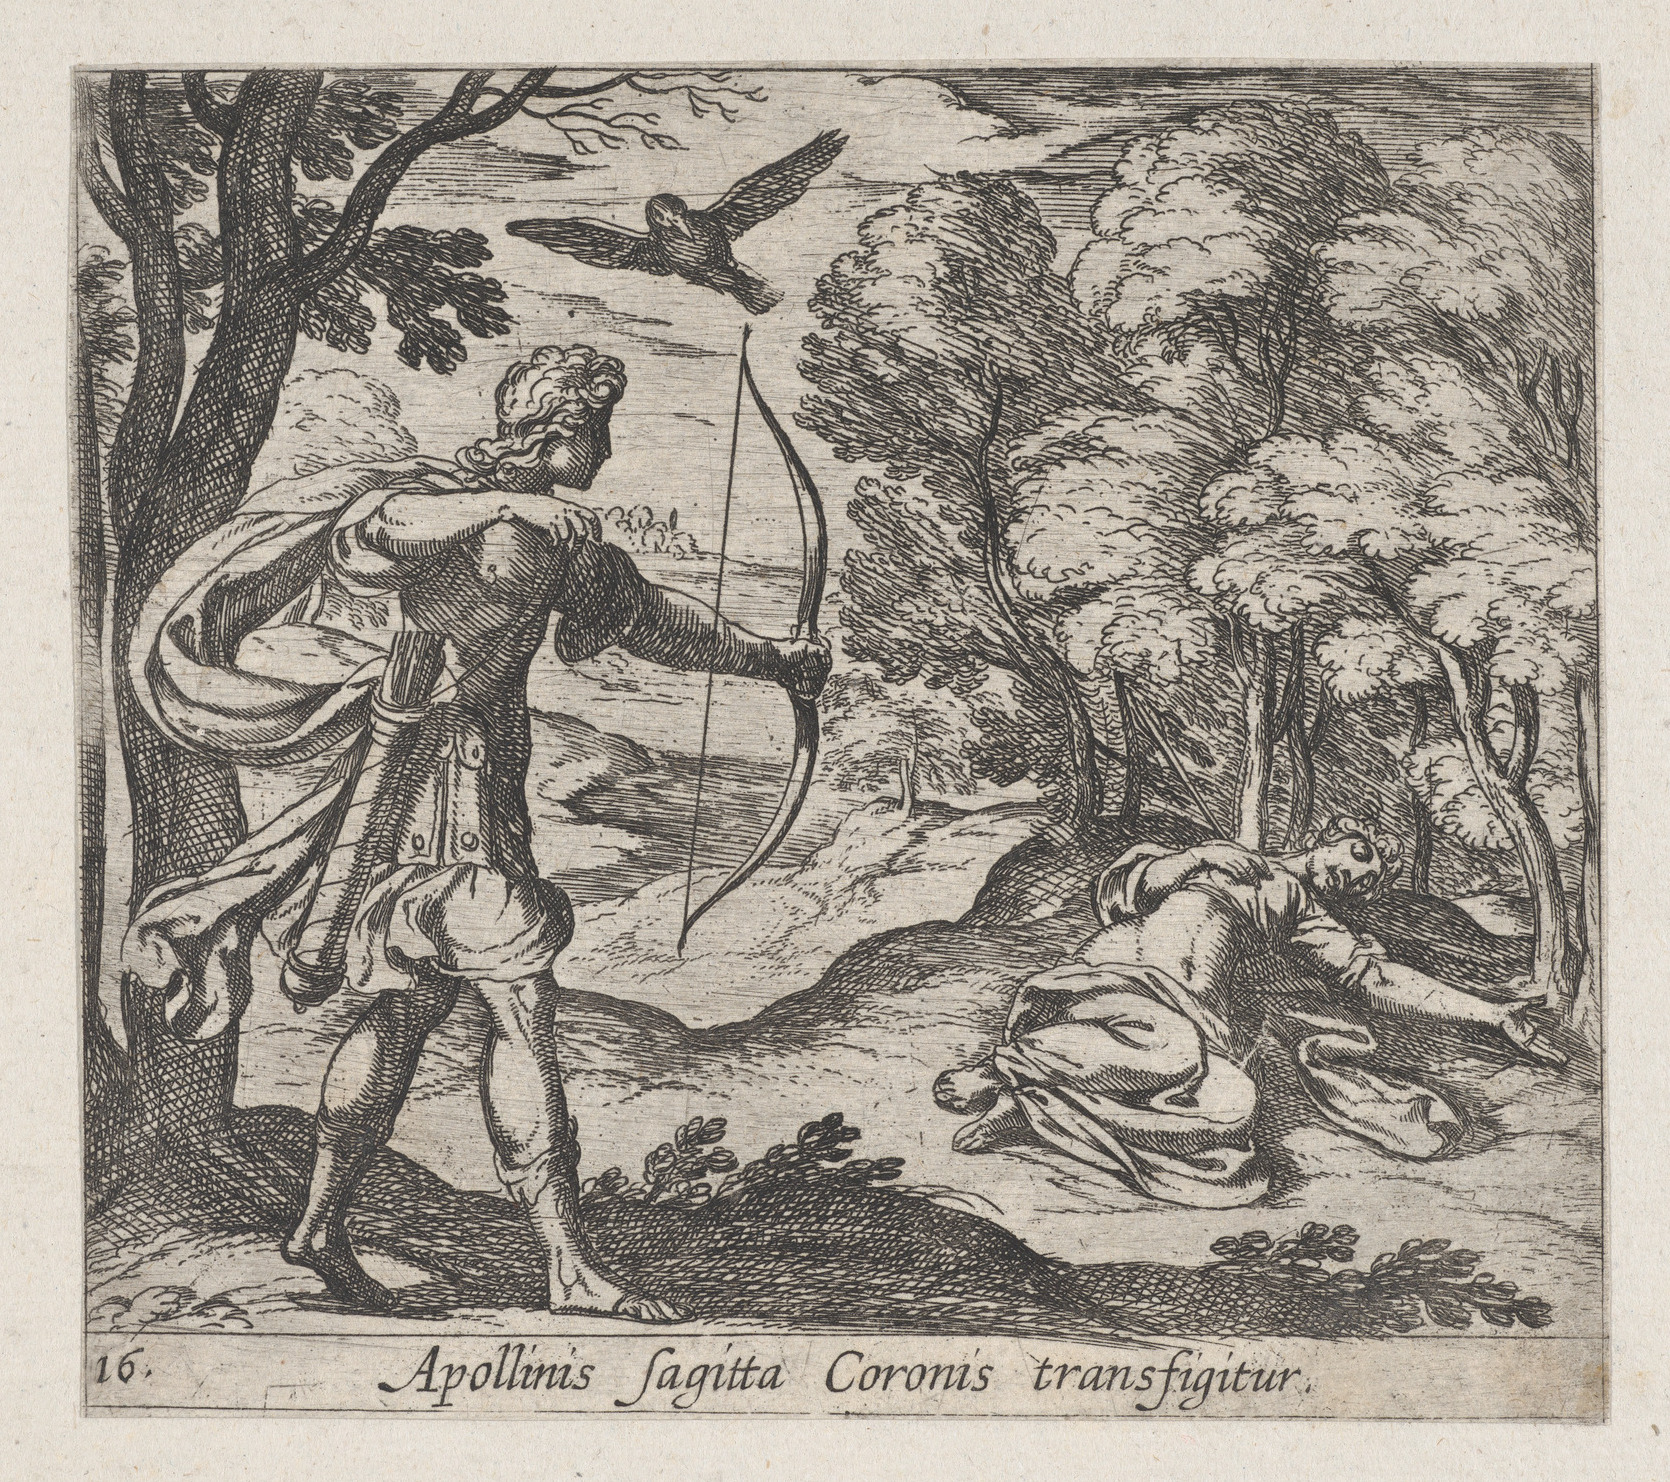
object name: print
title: Plate 16: Apollo Killing Coronis (Appolinis sagitta Coronis transfigitur), from Ovid's 'Metamorphoses'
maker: antonio tempesta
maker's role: artist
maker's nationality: italian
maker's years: 1555-1630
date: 1606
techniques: etching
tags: bow and arrow,women,apollo